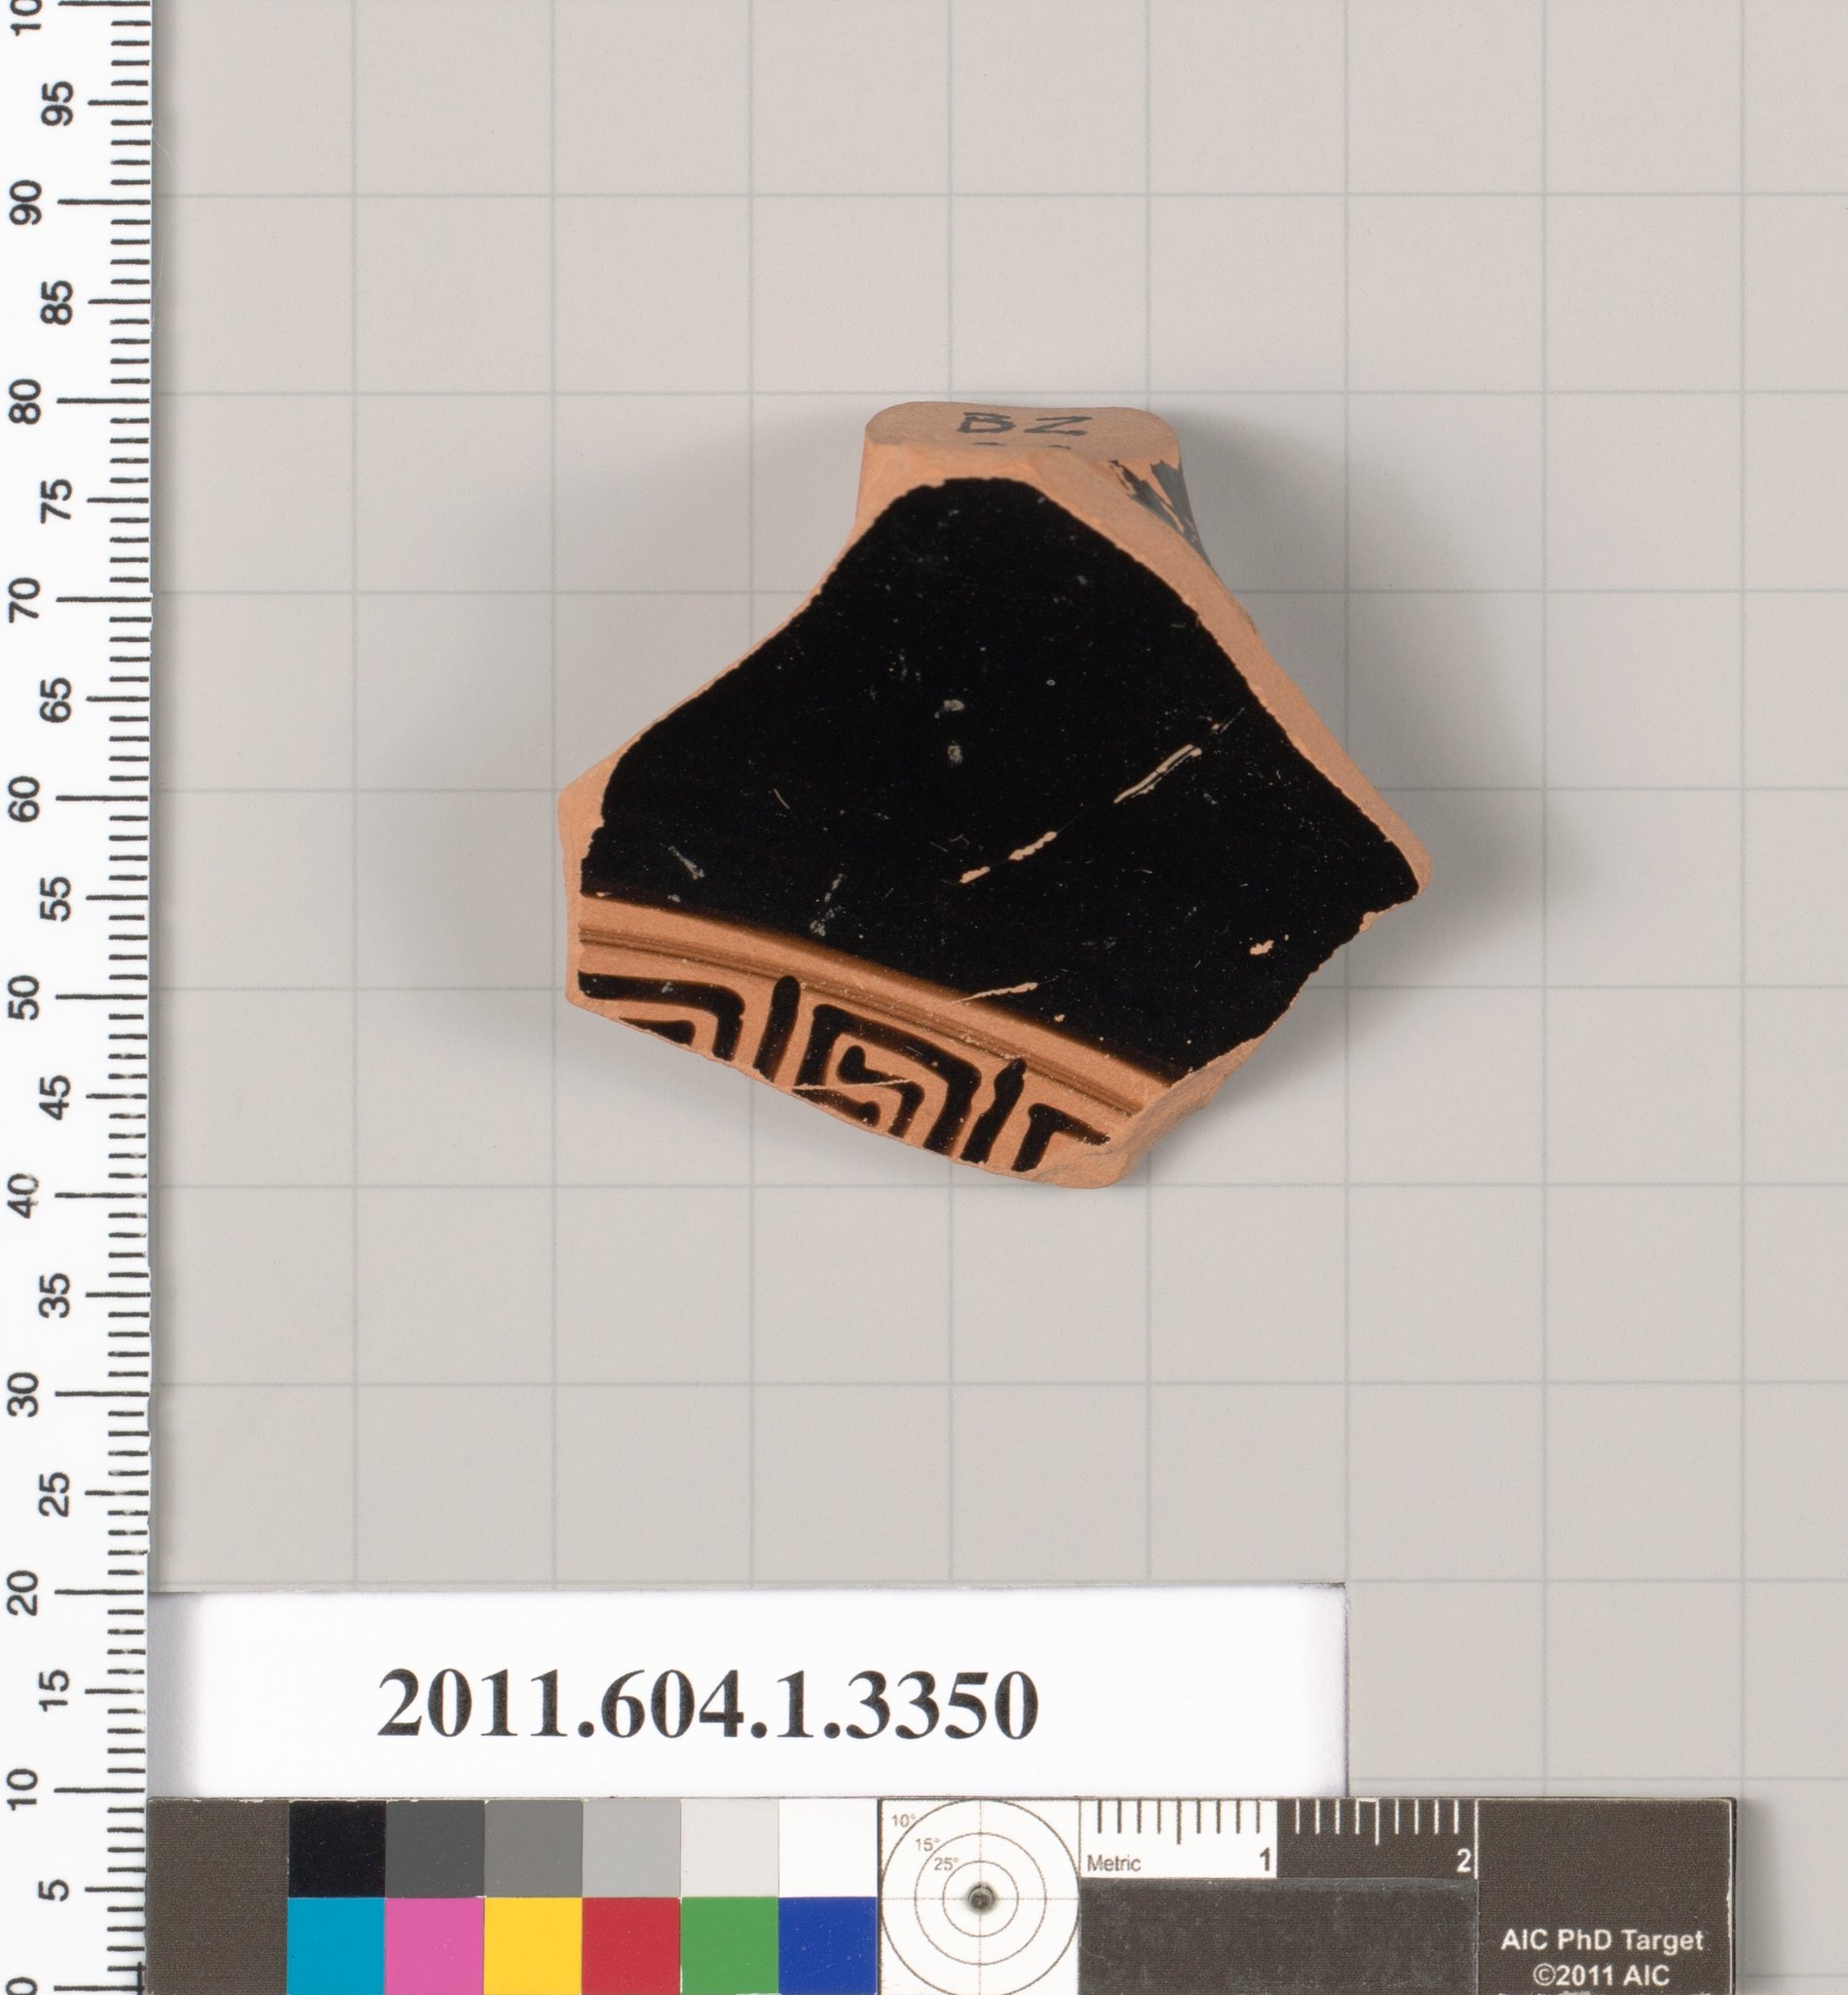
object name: kylix fragment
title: Terracotta fragment of a kylix (drinking cup)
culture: greek, attic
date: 500-470 BCE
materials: terracotta